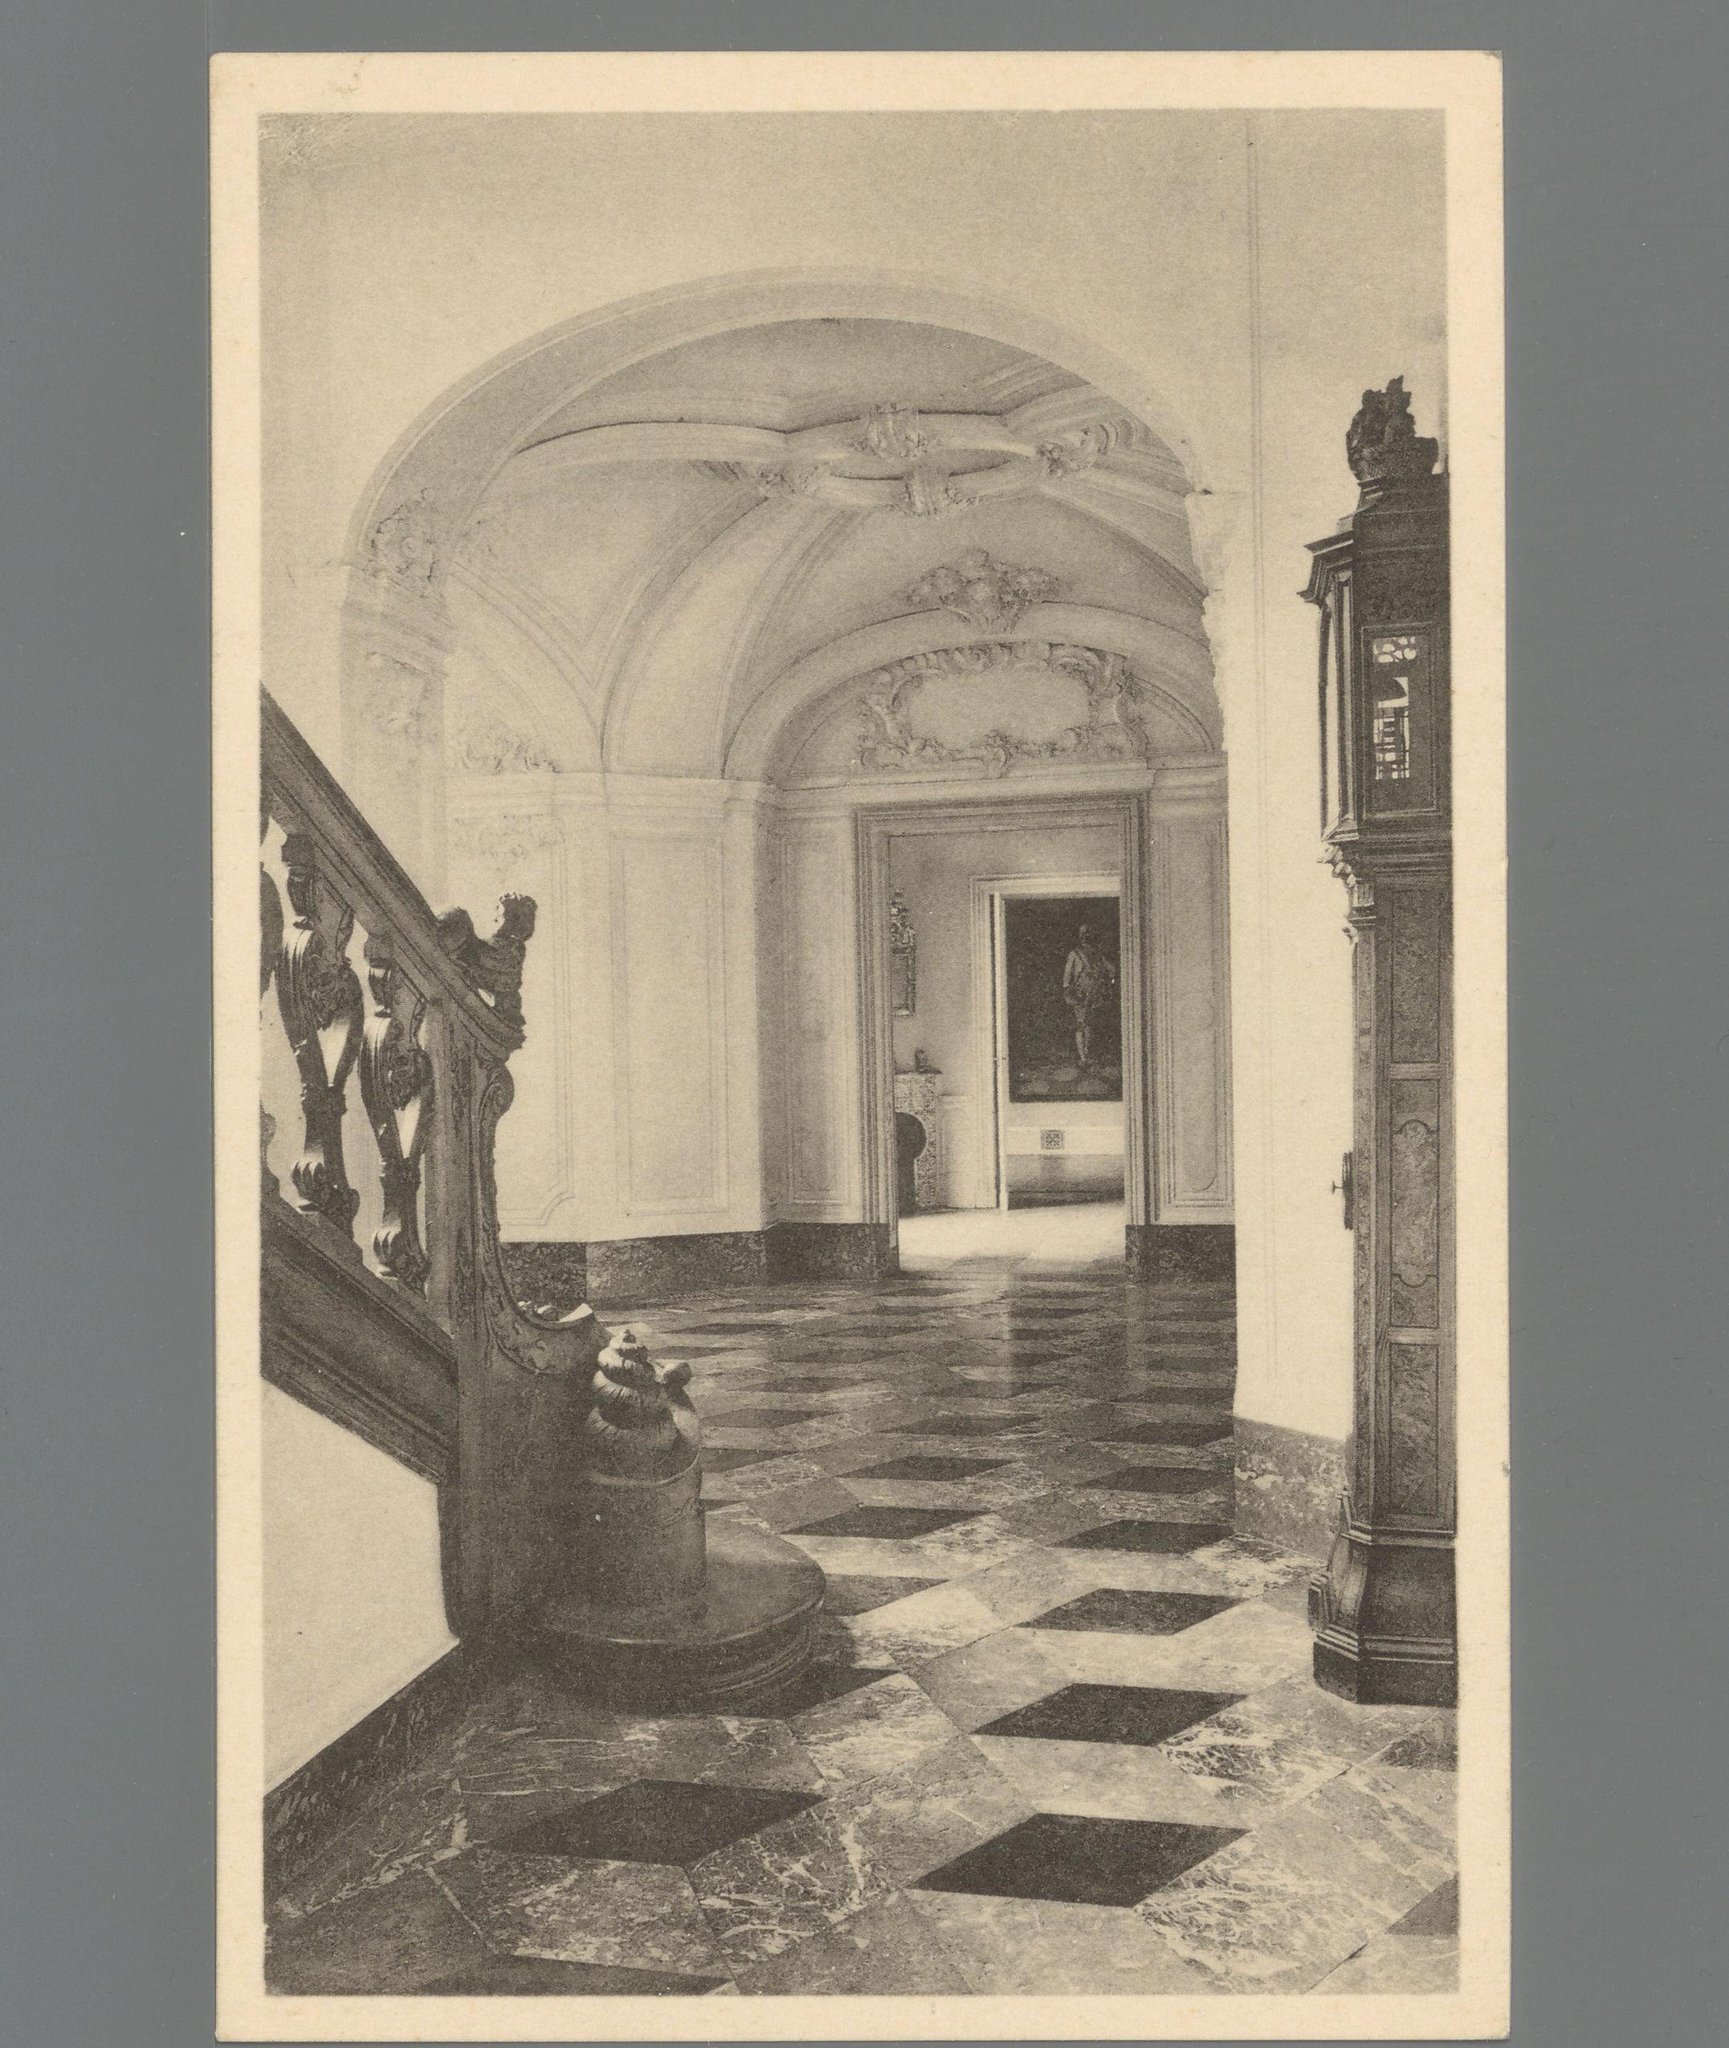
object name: ansichtkaart, prentbriefkaart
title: Hôtel de Croix, à Namur. Vestibule décoré de stucs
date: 1907-1913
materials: cardboard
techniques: photograph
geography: namur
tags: vestibule, hall, permanent exhibition, museum, interior ~ representation of a building